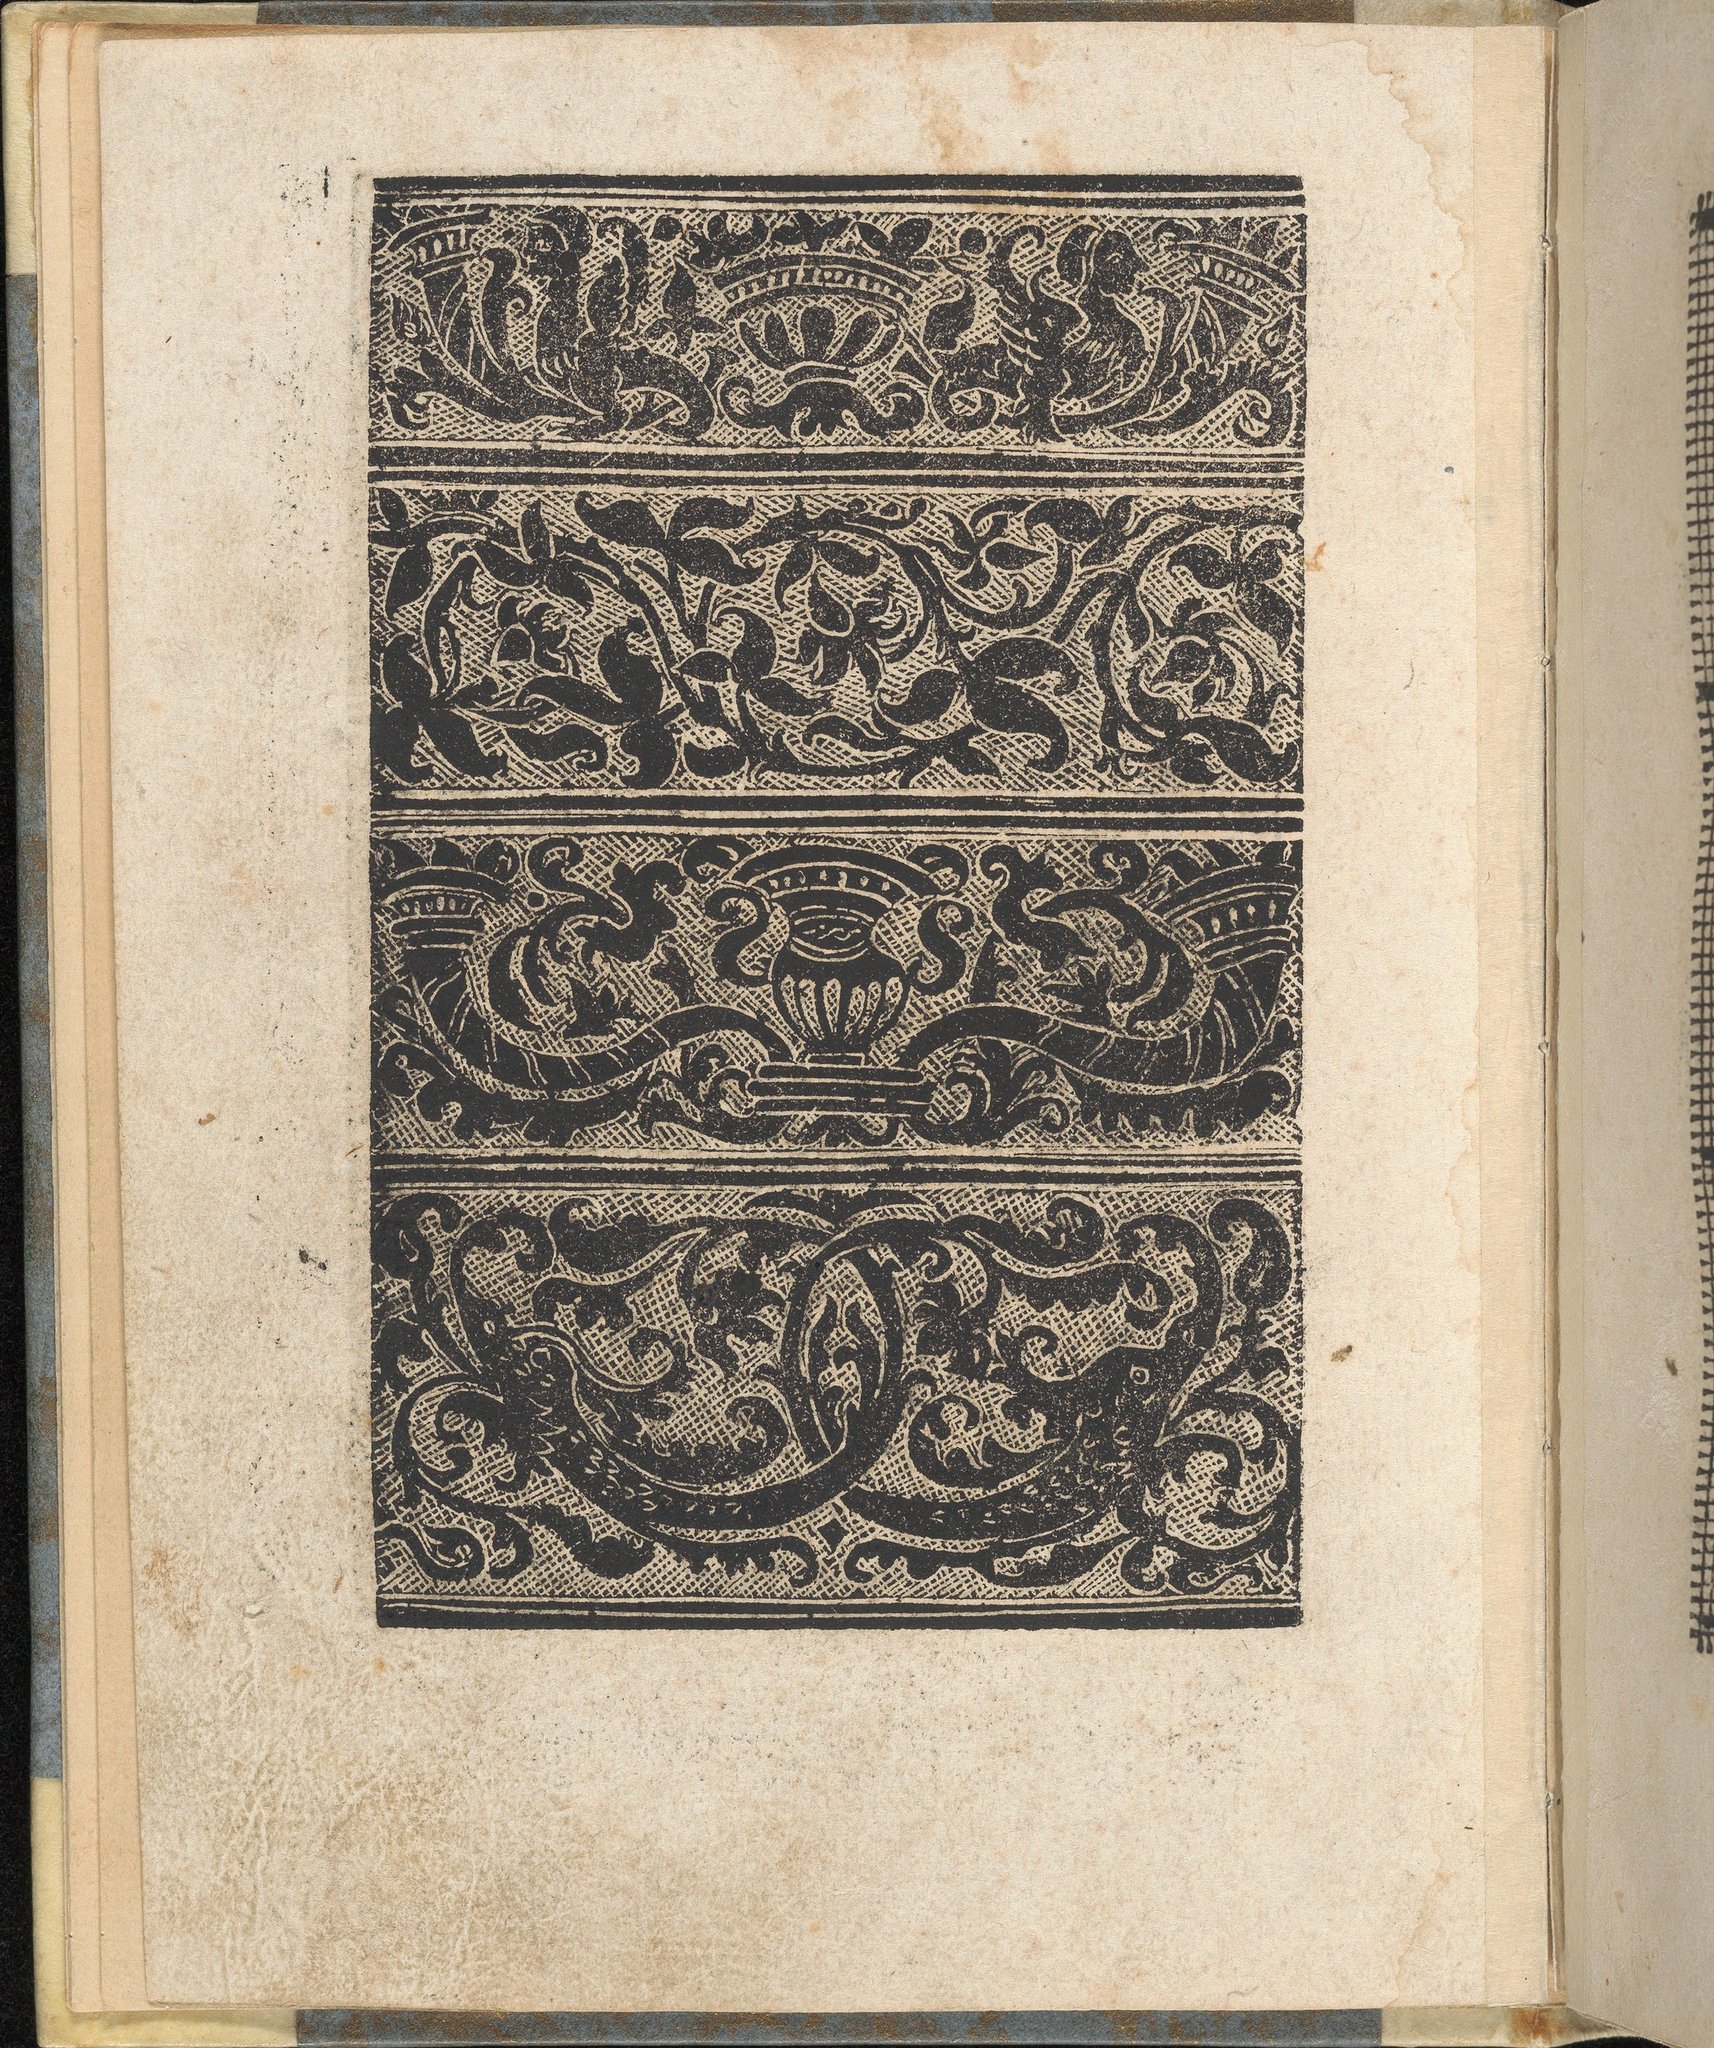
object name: book print ornament architecture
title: Ein ney Furmbüchlein, Page 2, recto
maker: johann schönsperger the younger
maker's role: publisher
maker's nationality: german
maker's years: 1490-1550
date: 1525-1529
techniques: woodcut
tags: ornament